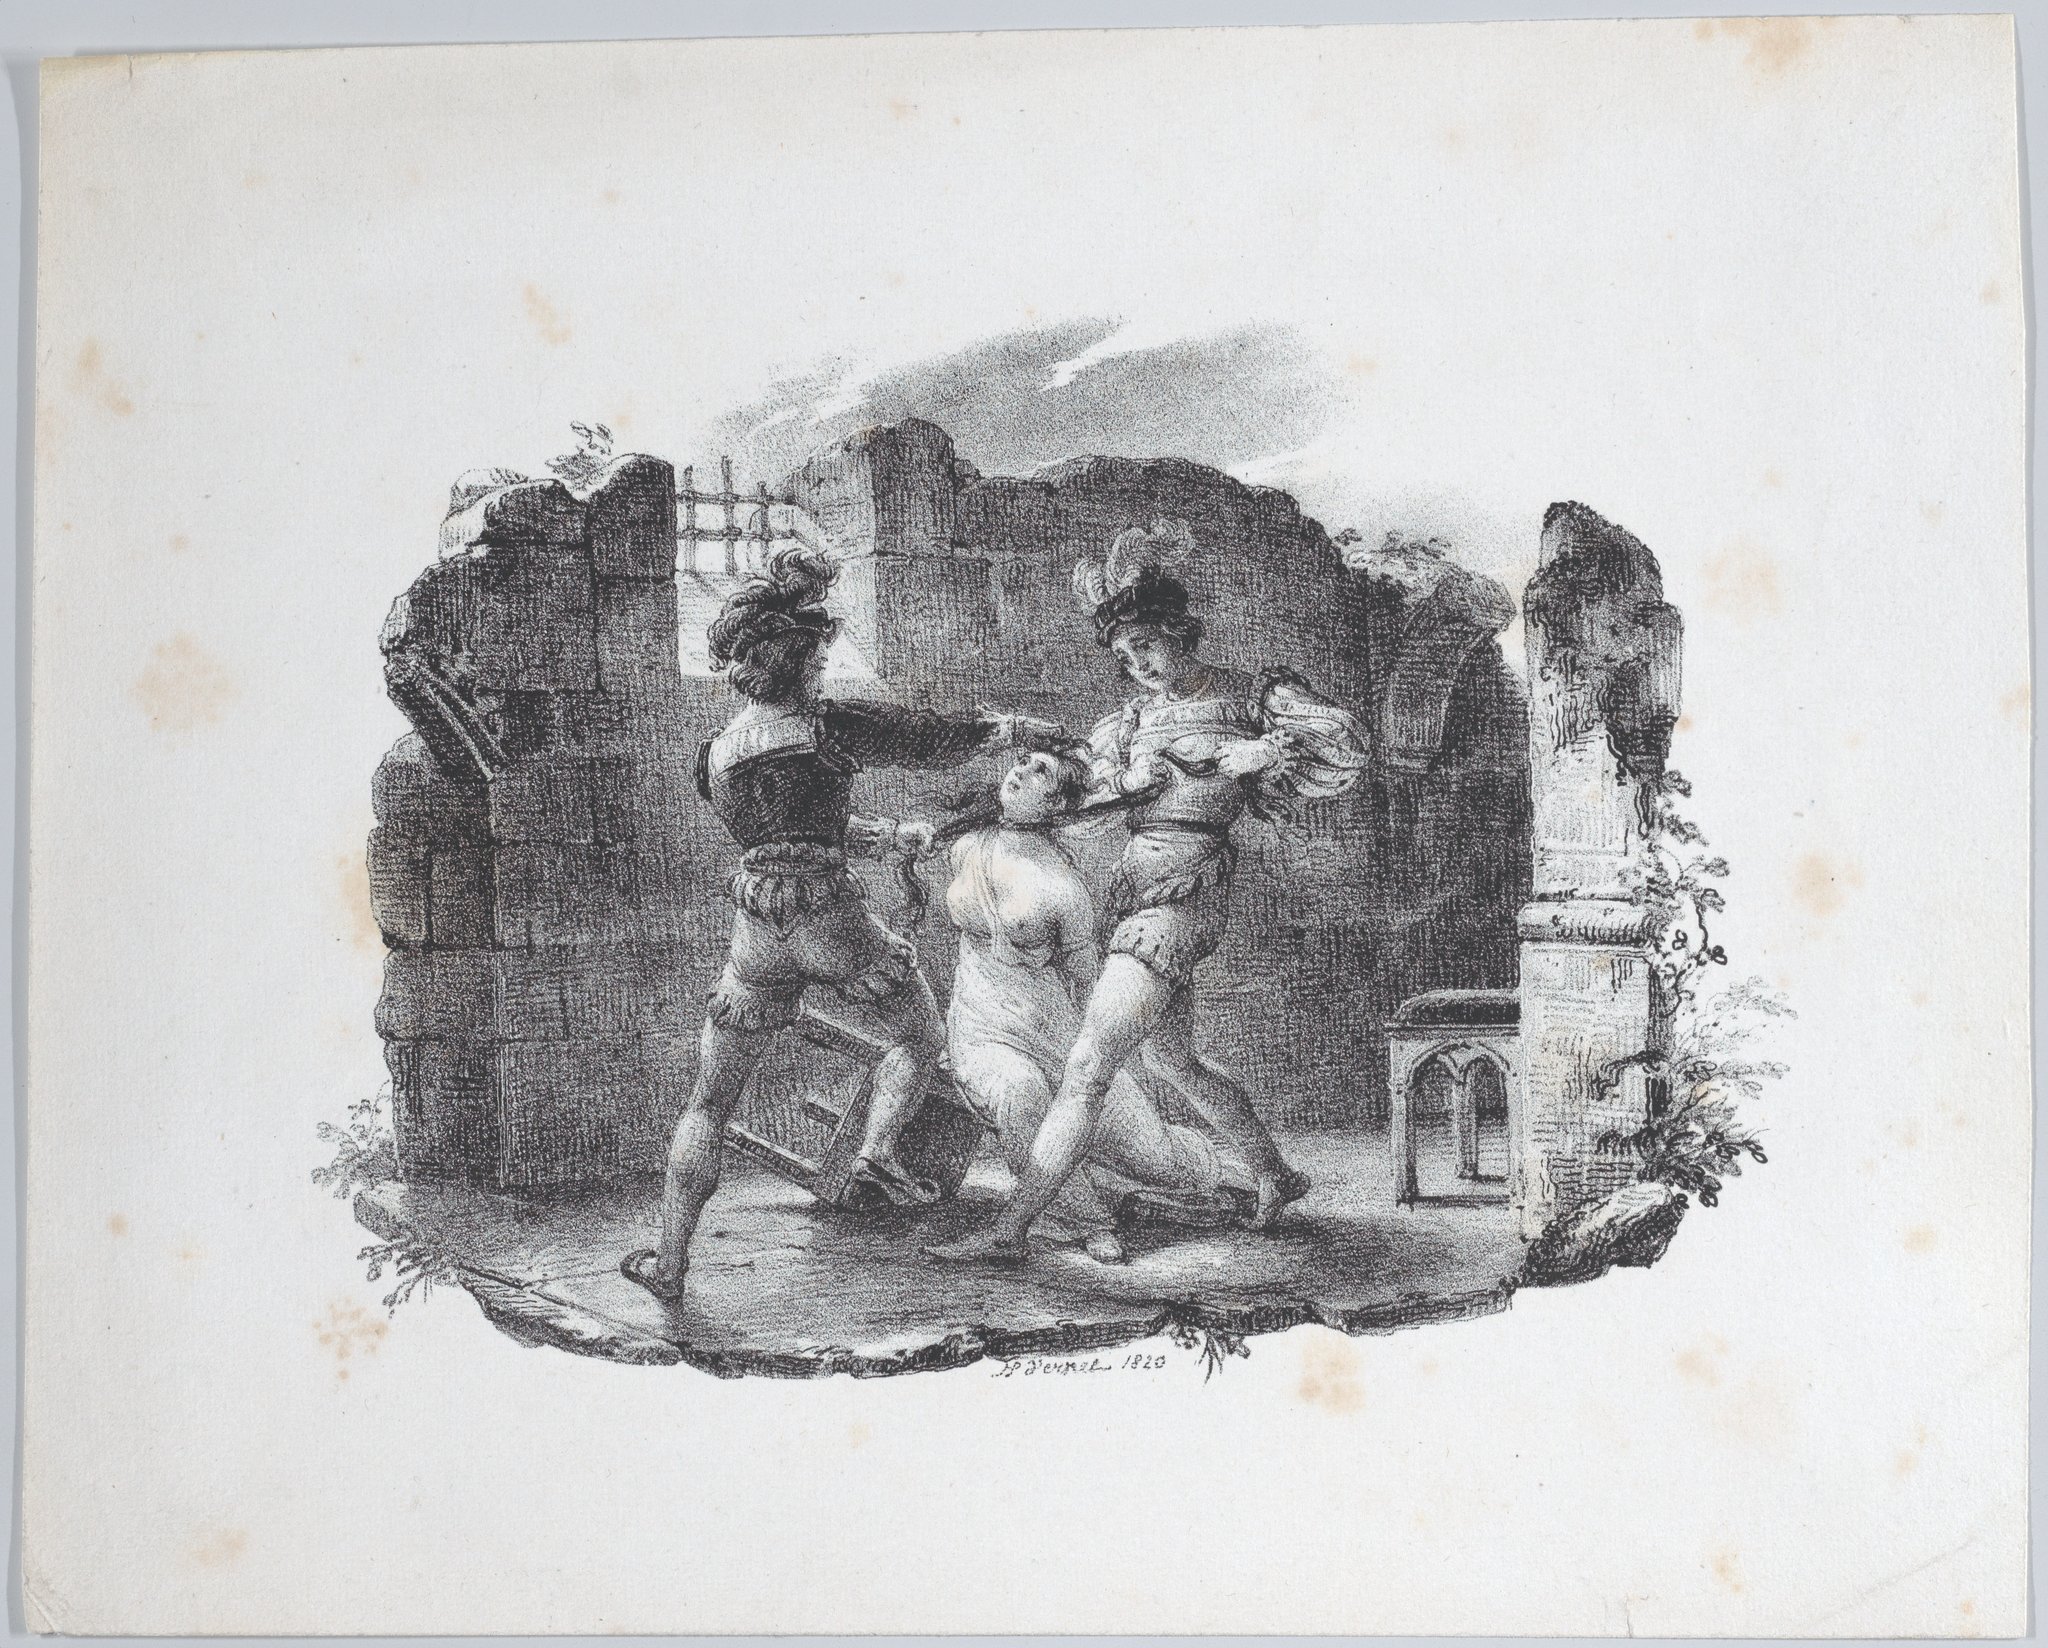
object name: print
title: Death of Margaret of Burgundy Strangled in Prison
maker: horace vernet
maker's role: artist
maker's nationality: french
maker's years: 1789-1863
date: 1820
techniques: lithograph